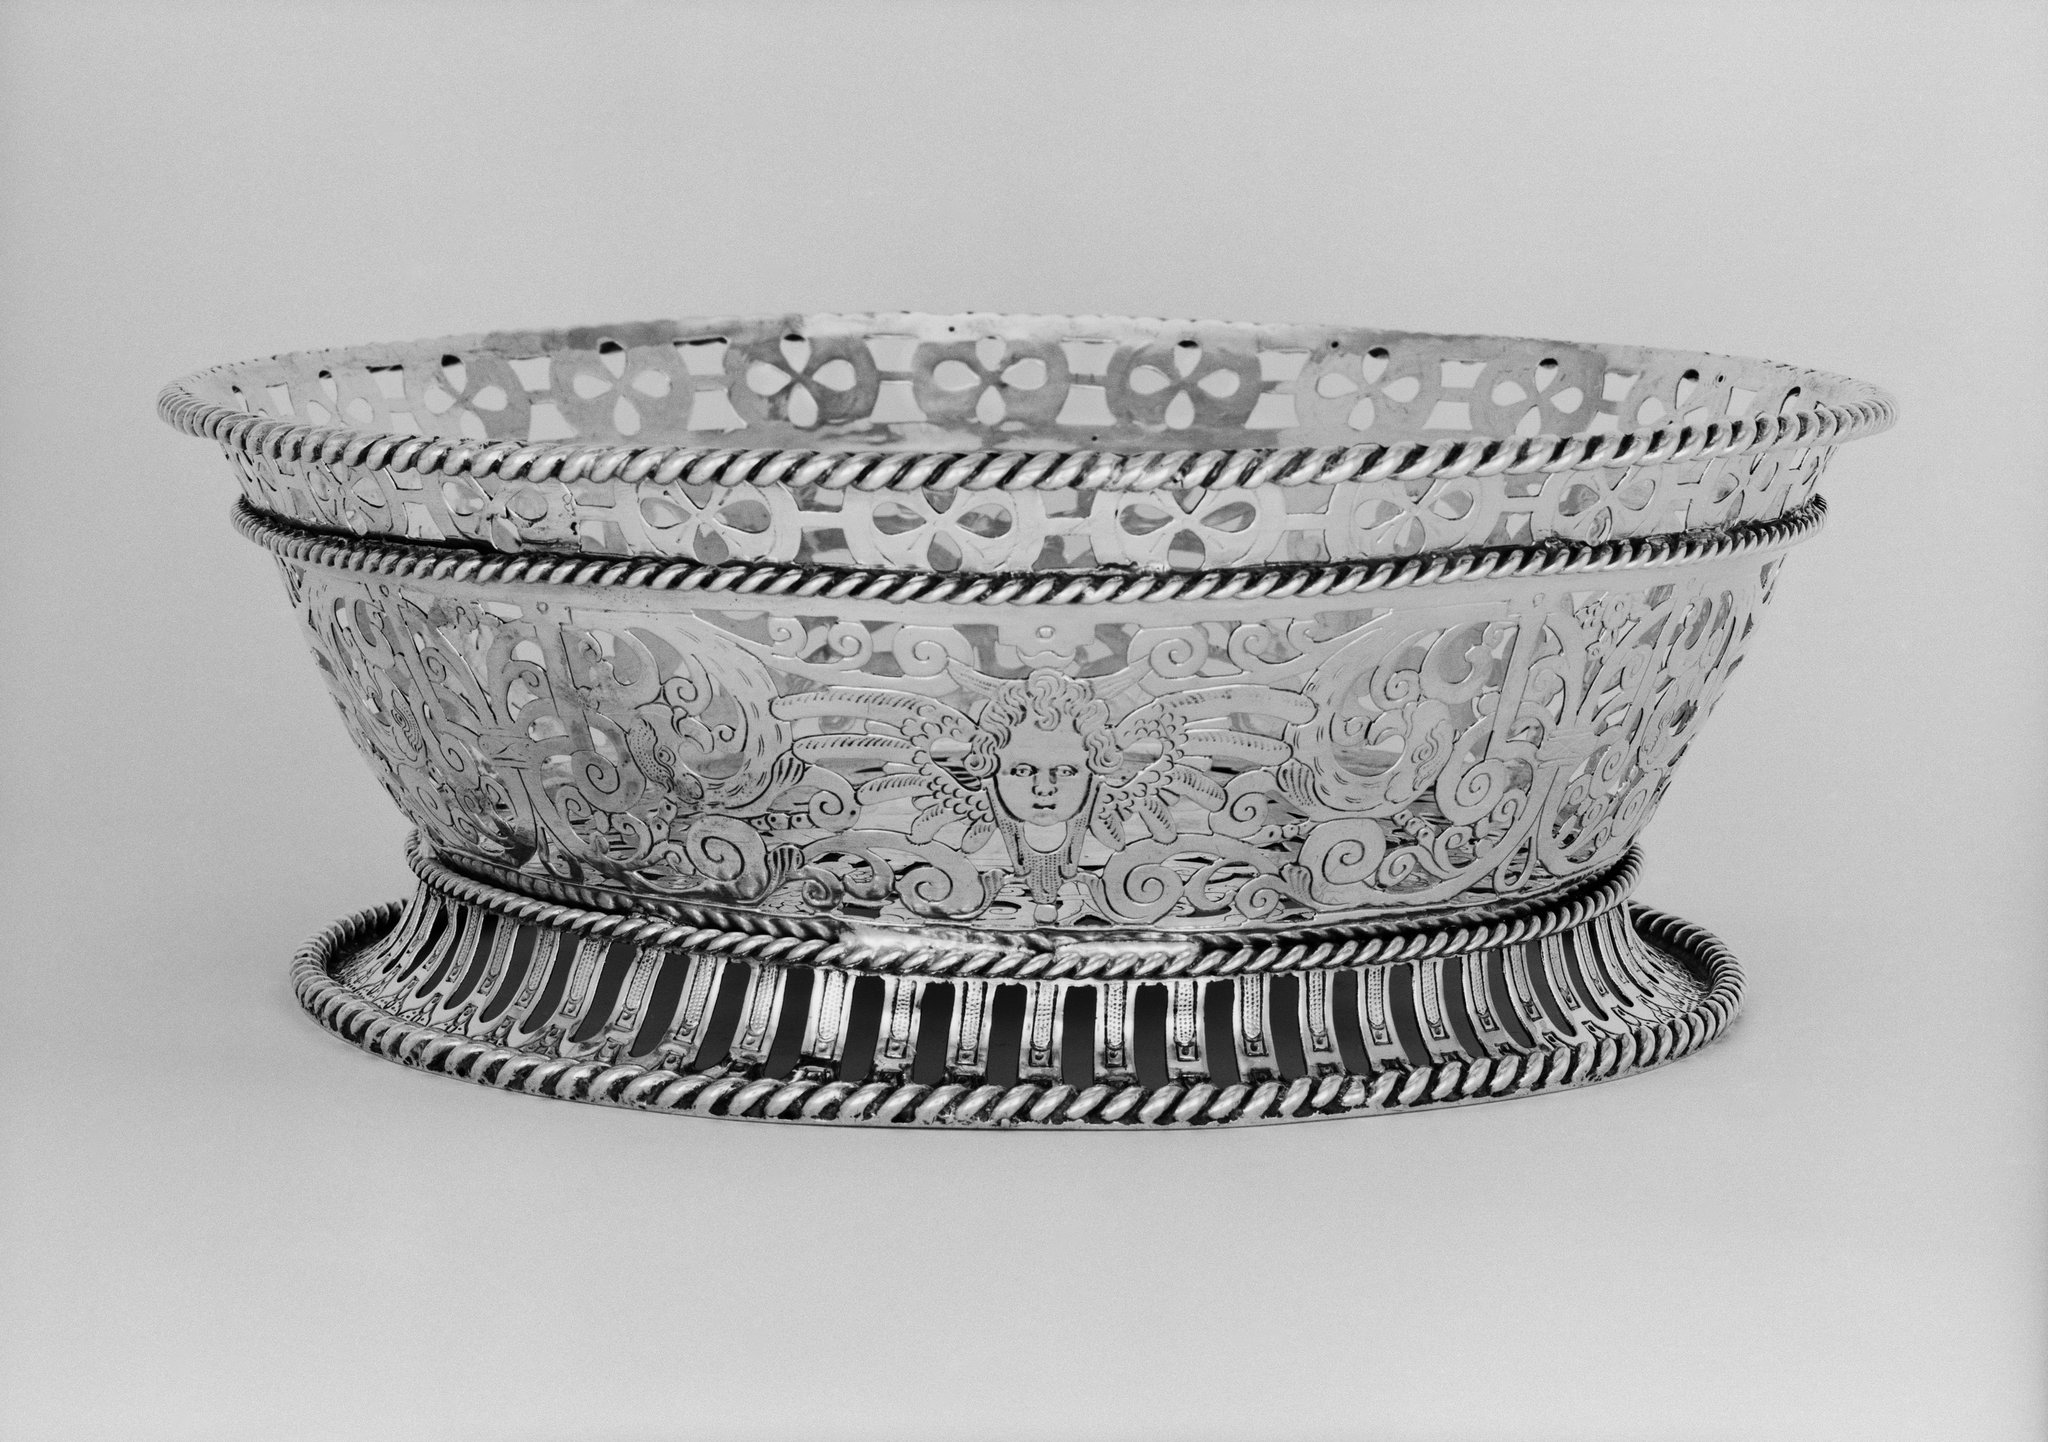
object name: basket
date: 1641-1642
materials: silver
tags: faces